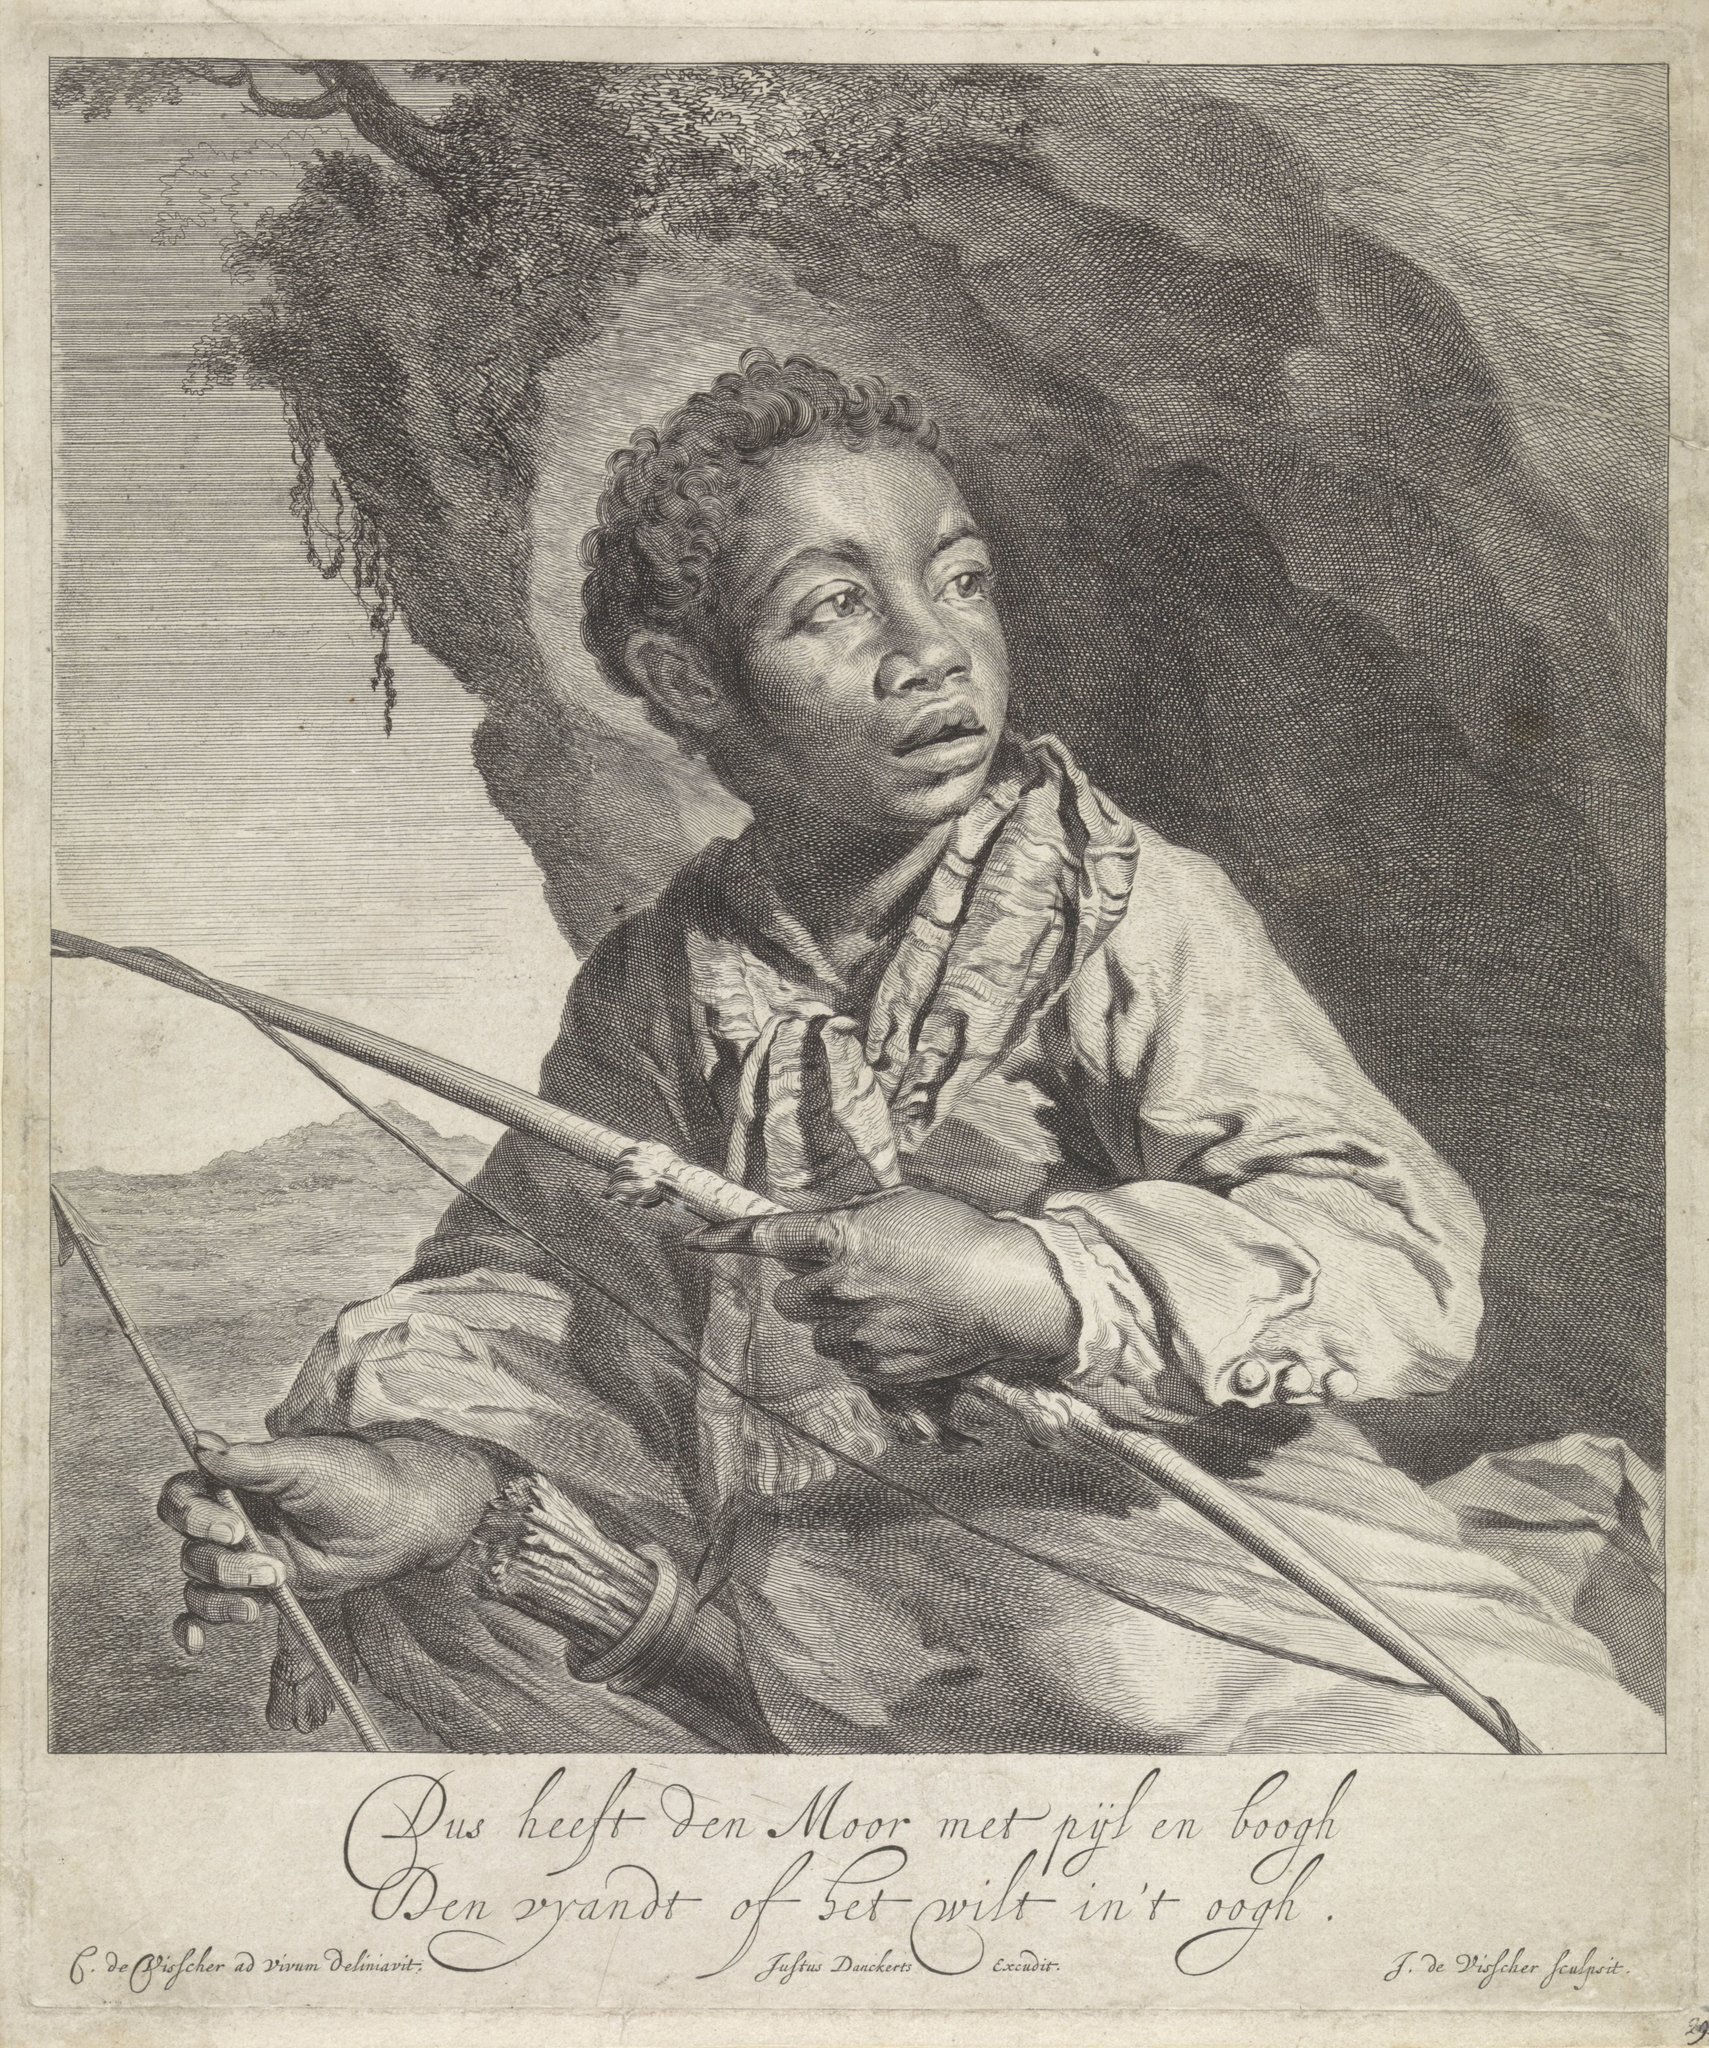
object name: print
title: Boogschutter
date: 1650-1701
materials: paper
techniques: engraving, etching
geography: amsterdam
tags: archer's weapons: bow and arrow, landscapes, africans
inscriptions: collector's mark: Lugt 240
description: Een jonge Afrikaan met een pijl en boog voor een rots. Op de achtergrond een landschap.